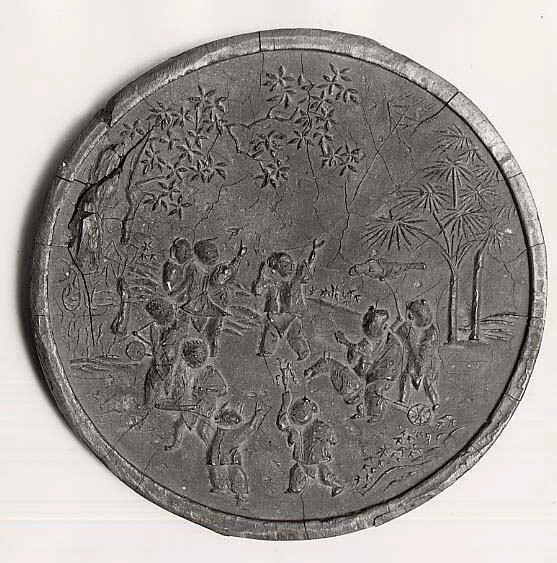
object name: ink tablet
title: Ink Tablet with "The Nine Sons" Design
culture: chinese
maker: wen ya guo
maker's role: artist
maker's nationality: chinese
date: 1867-1933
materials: ink